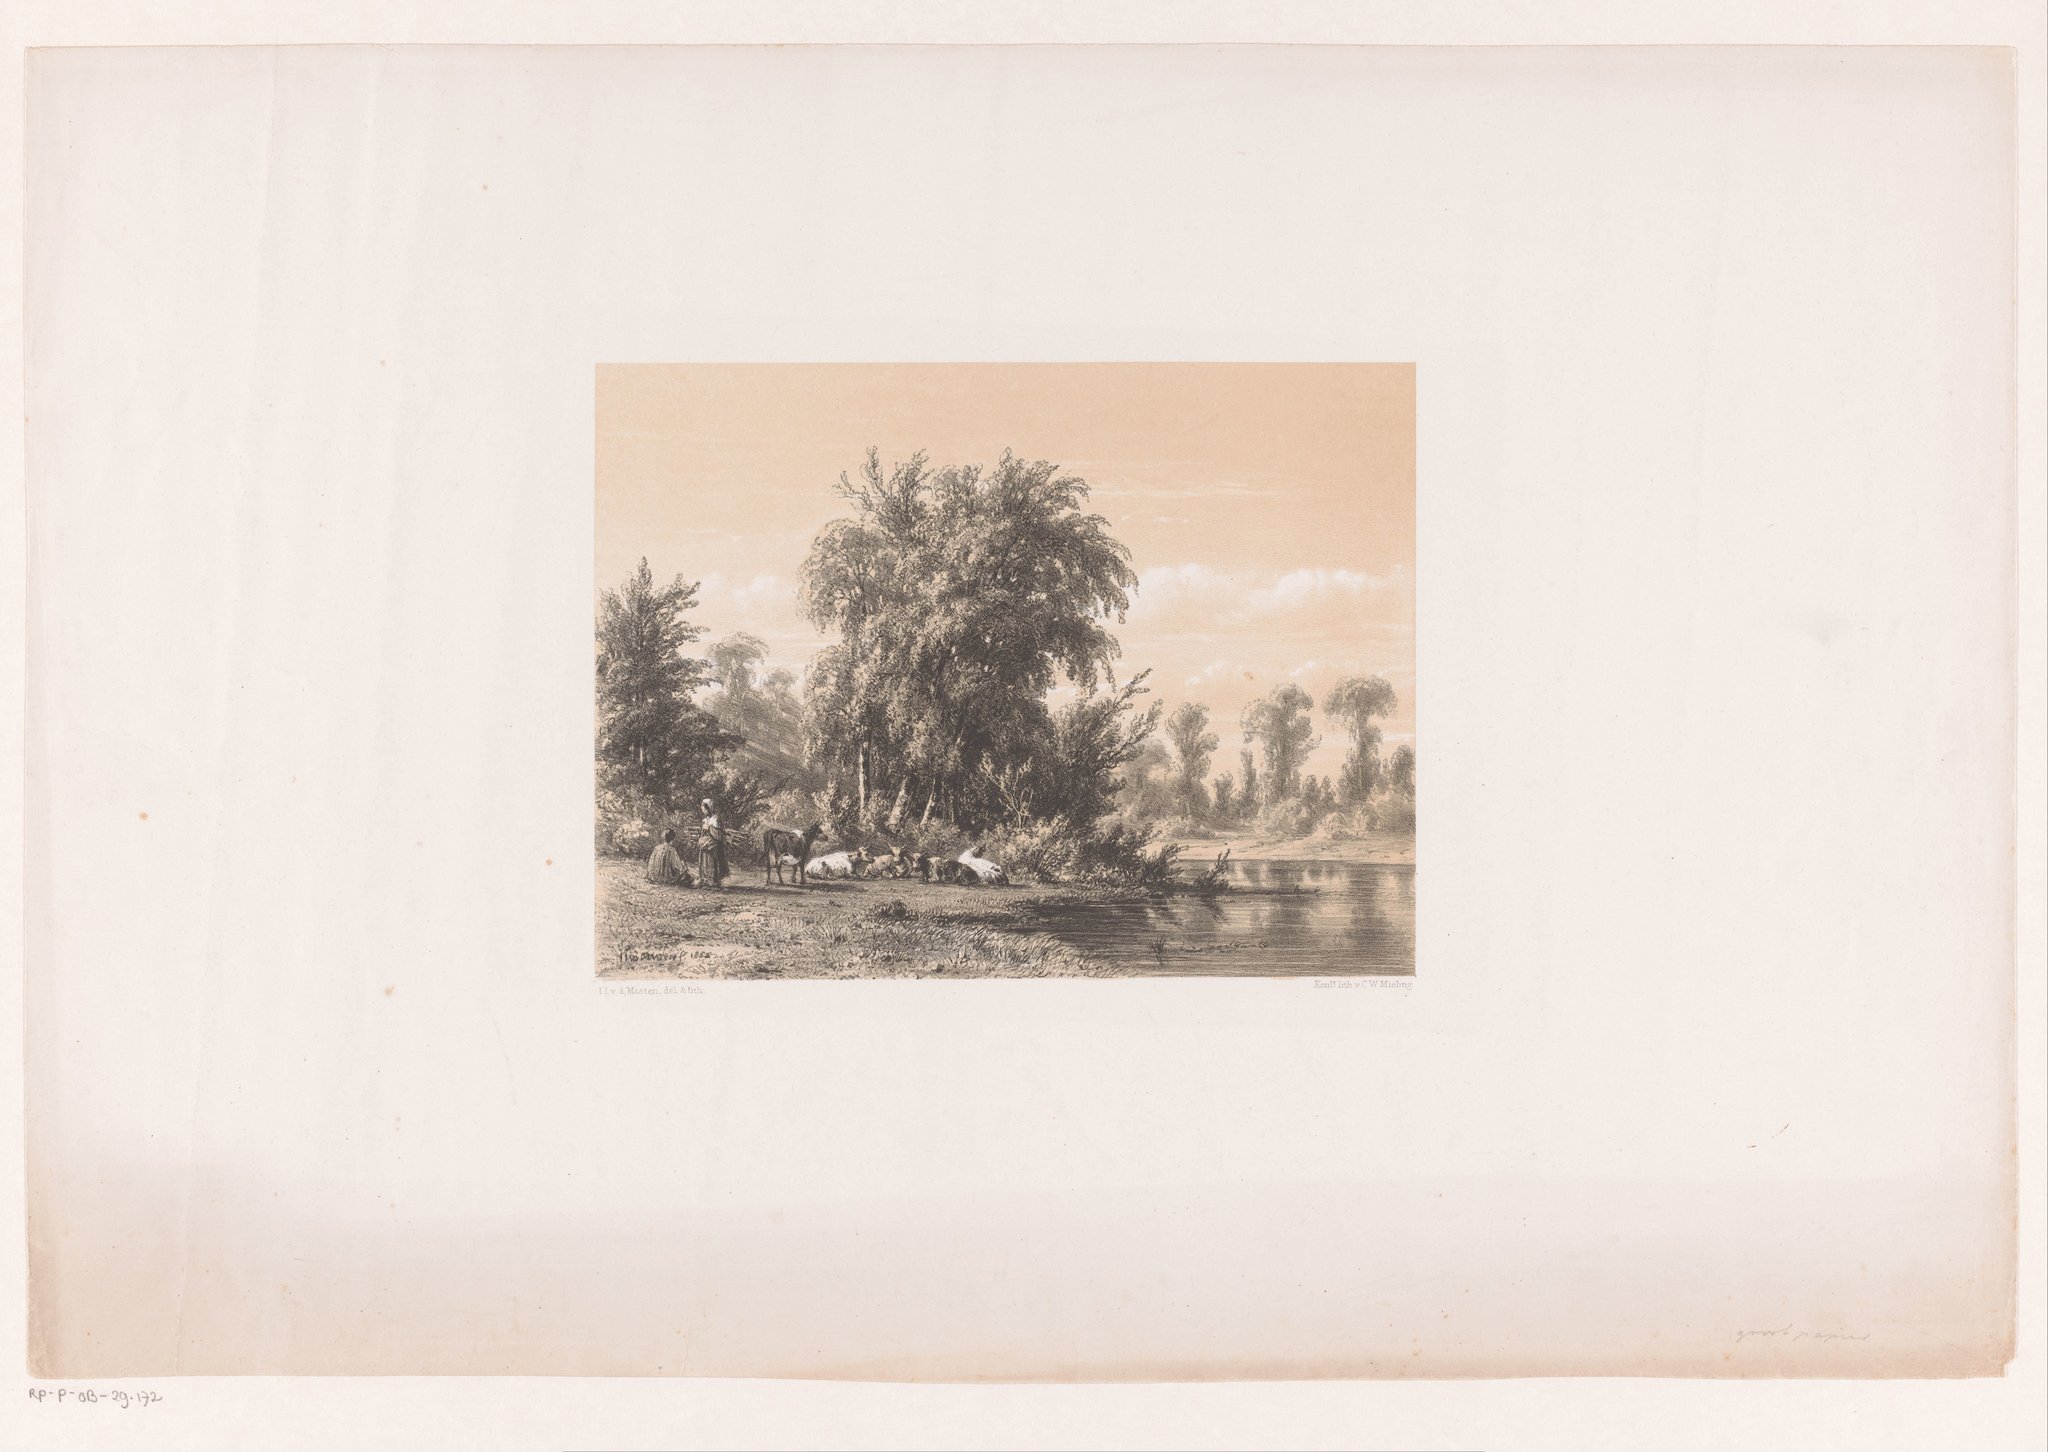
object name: print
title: Rustende koeien bij het water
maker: jacob jan van der maaten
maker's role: draughtsman, print maker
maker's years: 1820-1879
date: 1852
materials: paper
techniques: tone lithography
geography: the hague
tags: woodgathering, woodgatherer, bovine cattle, river (+ landscape with figures, staffage), herd, flock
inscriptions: collector's mark: Lugt 2228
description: Links bij de kudde een man en een vrouw. De vrouw heeft een bos hout bij zich.